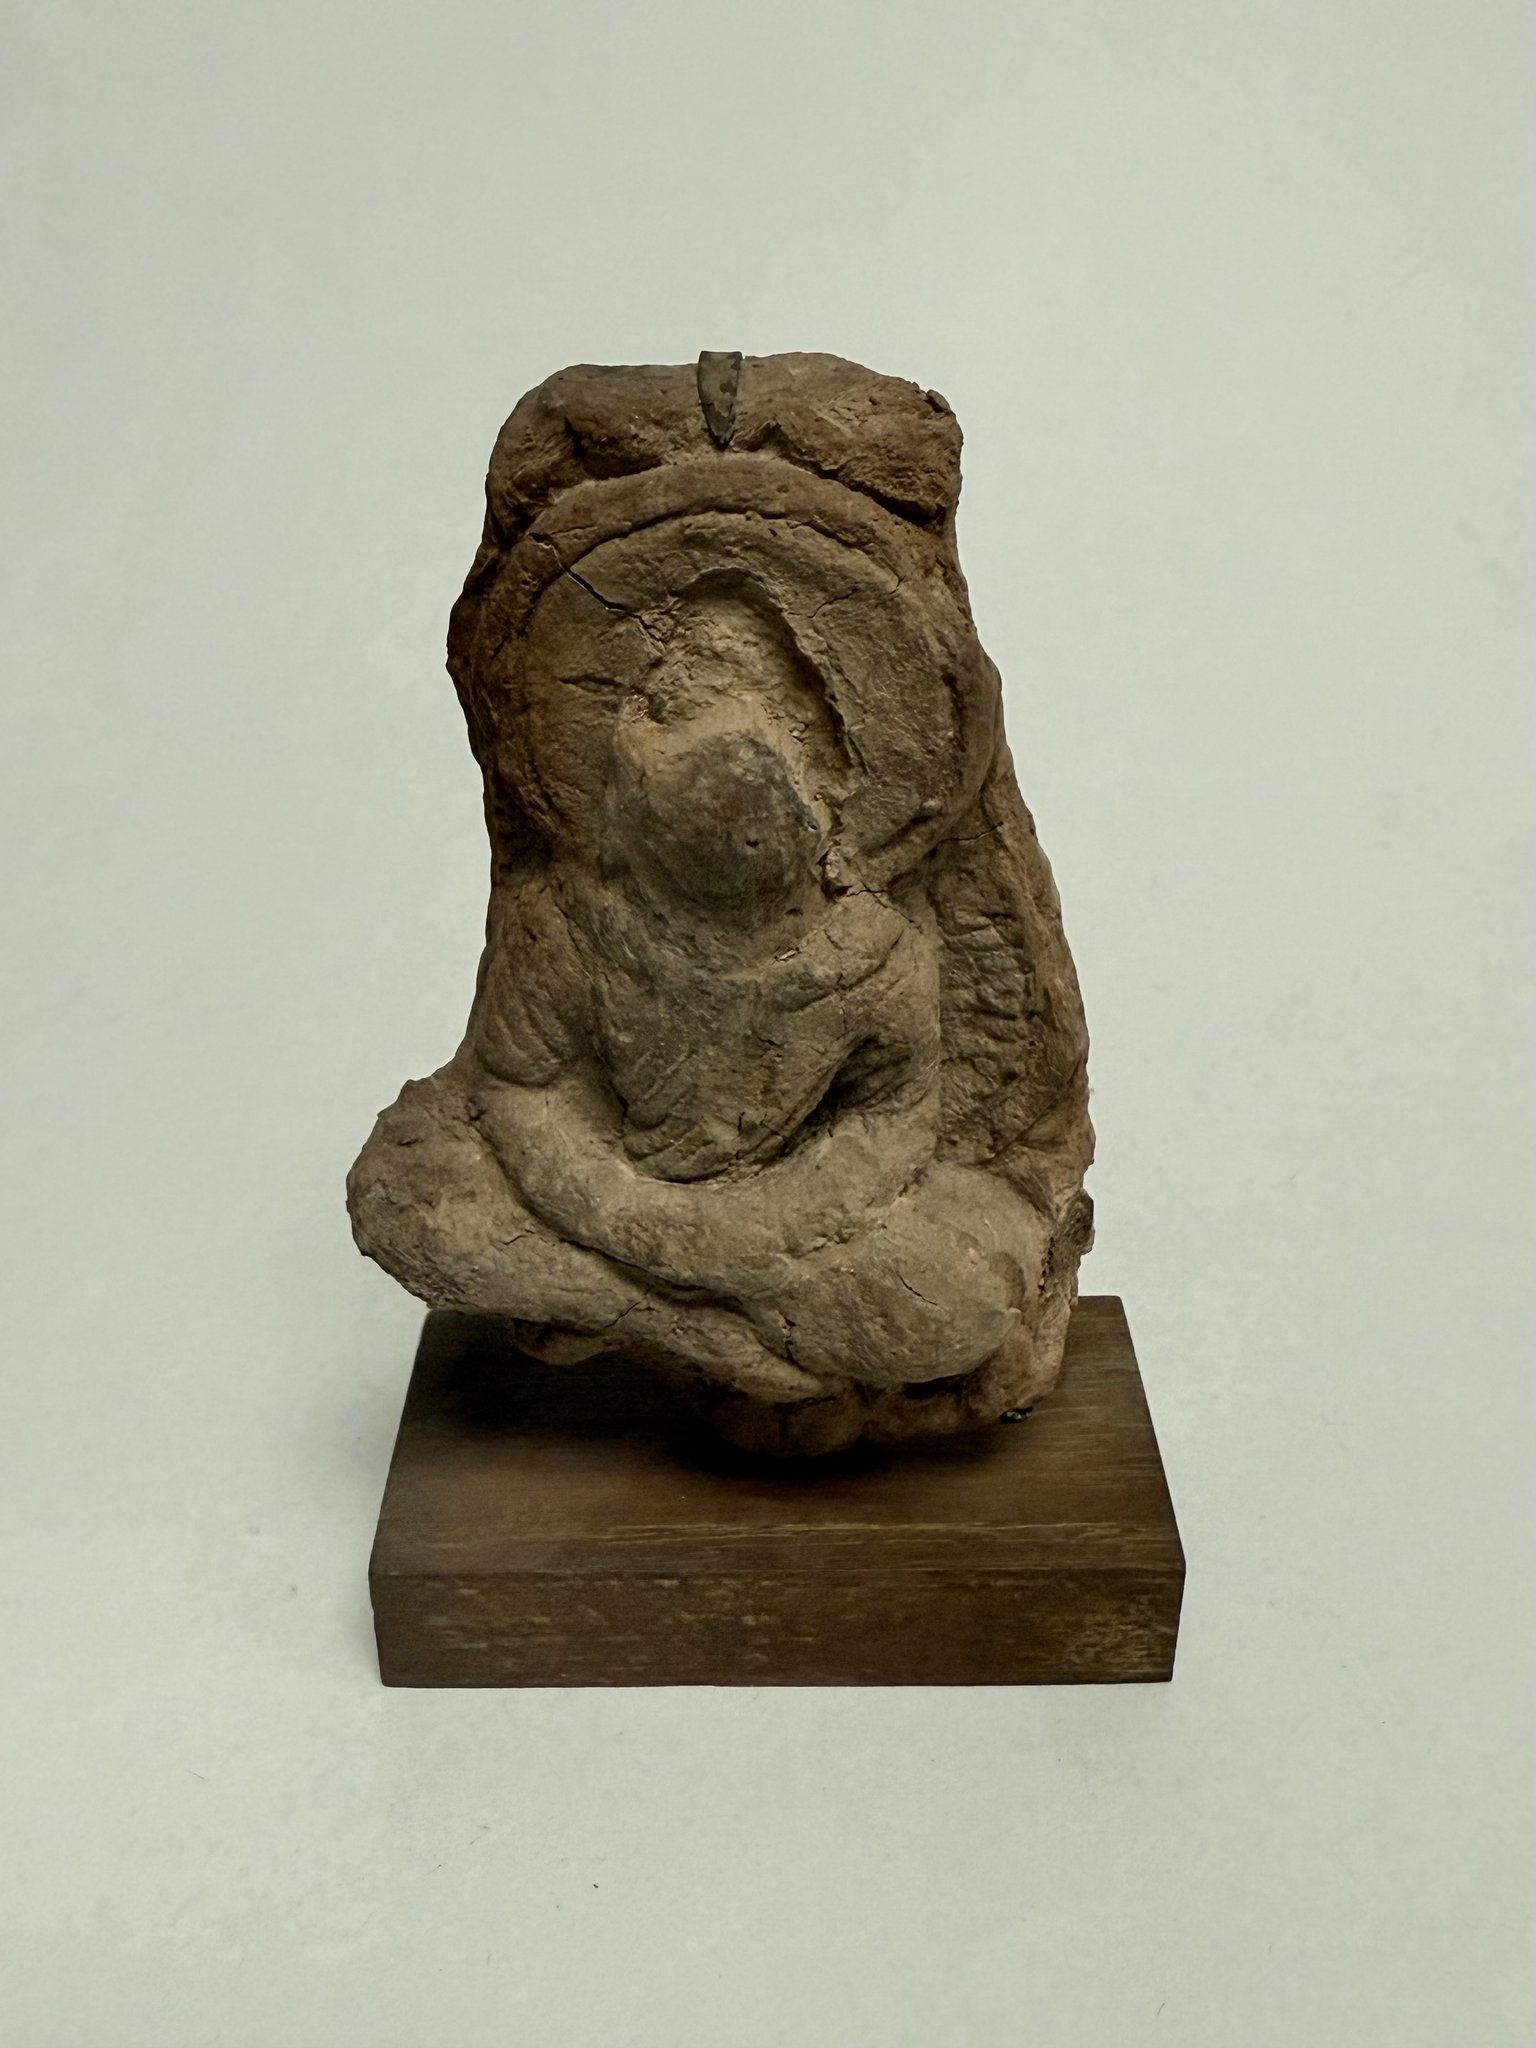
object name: relief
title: Fragment of a Relief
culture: central asian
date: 1101-1133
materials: clay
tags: buddha